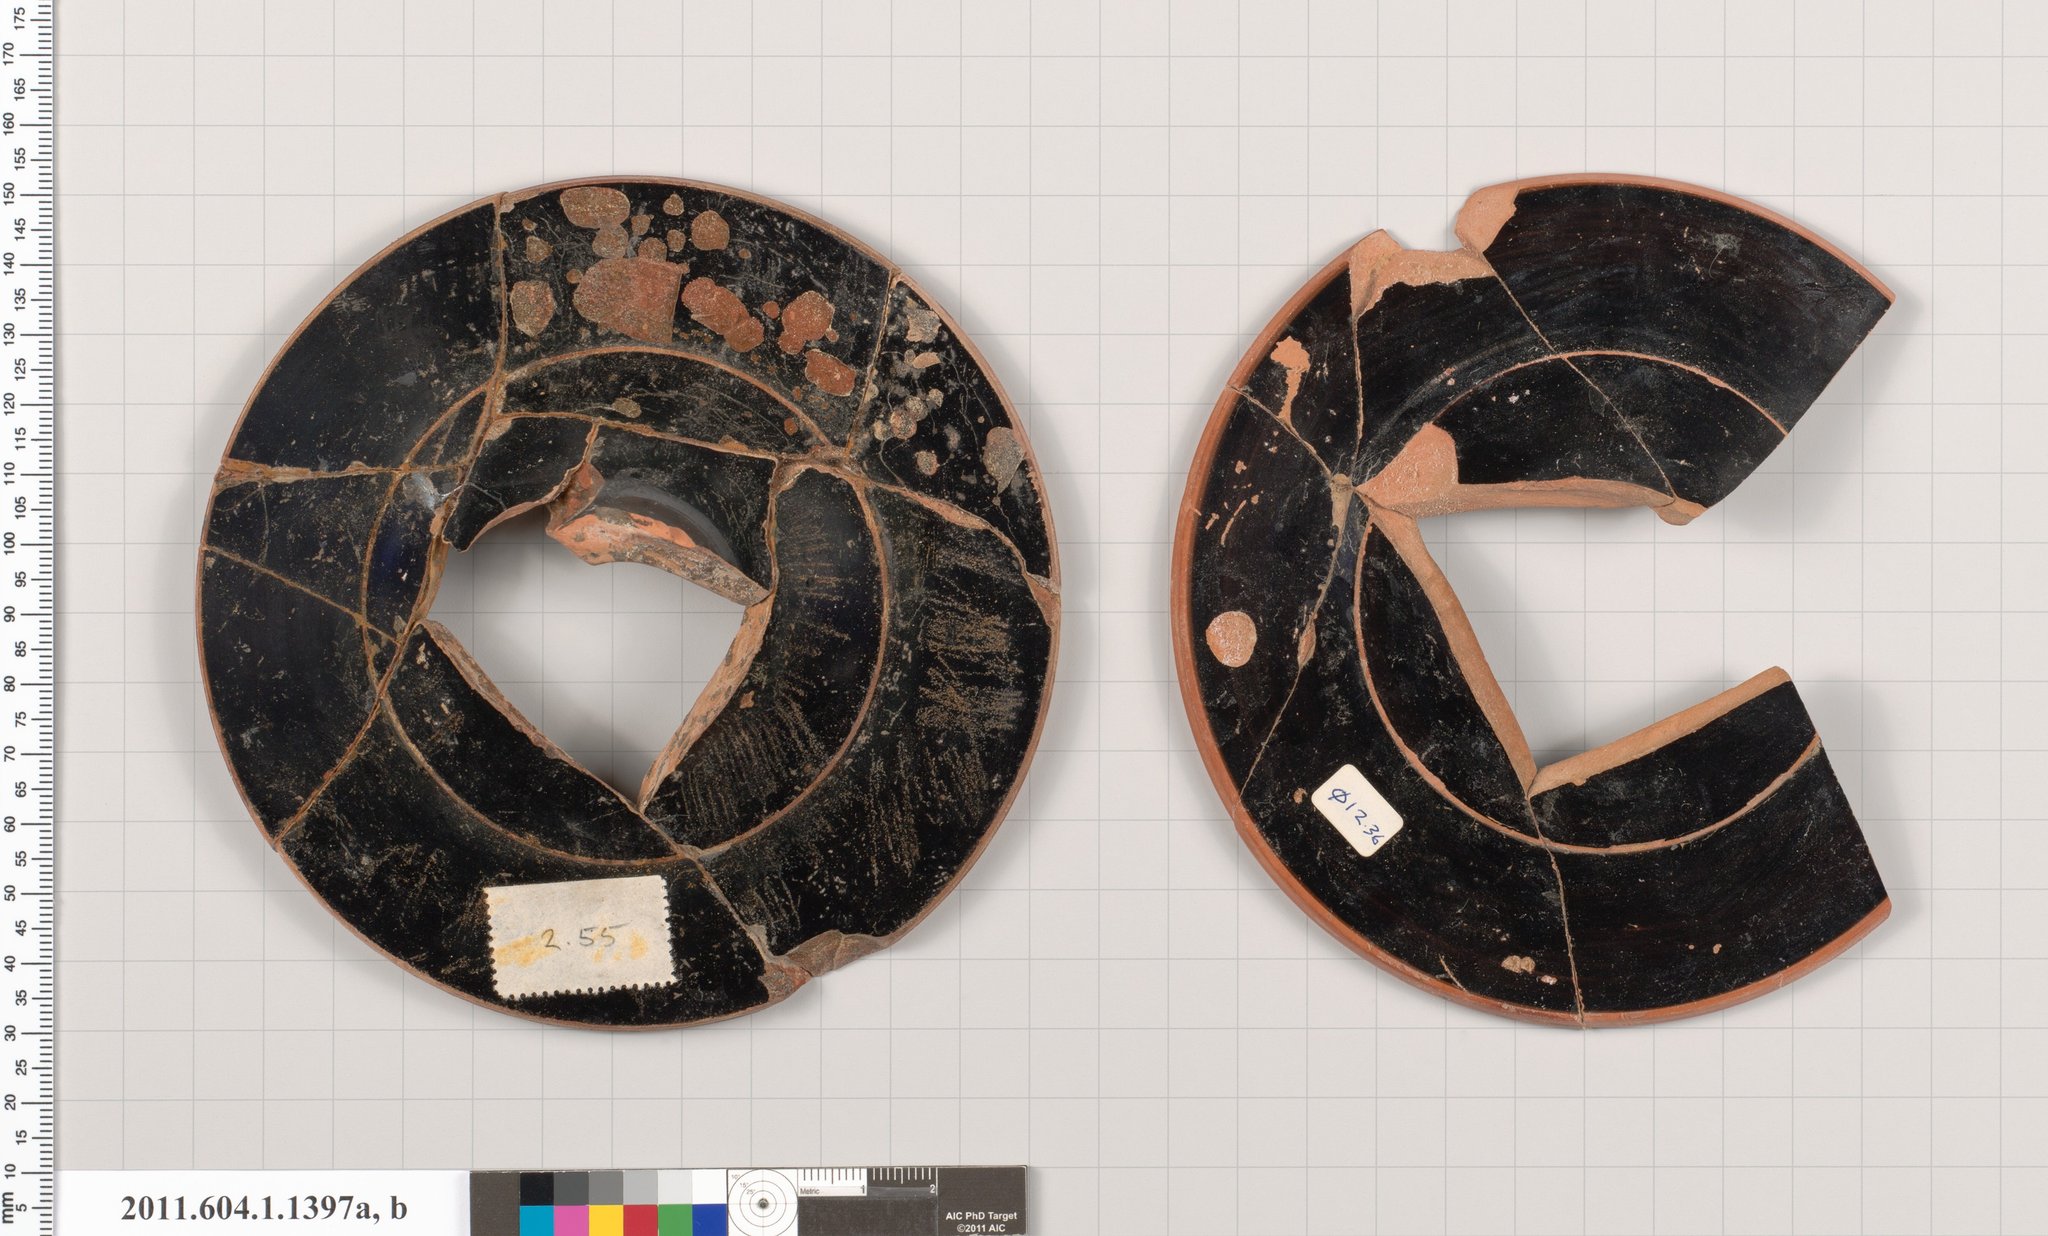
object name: kylix fragment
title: Terracotta fragments of kylikes (drinking cups)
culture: greek, attic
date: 500-401 BCE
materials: terracotta